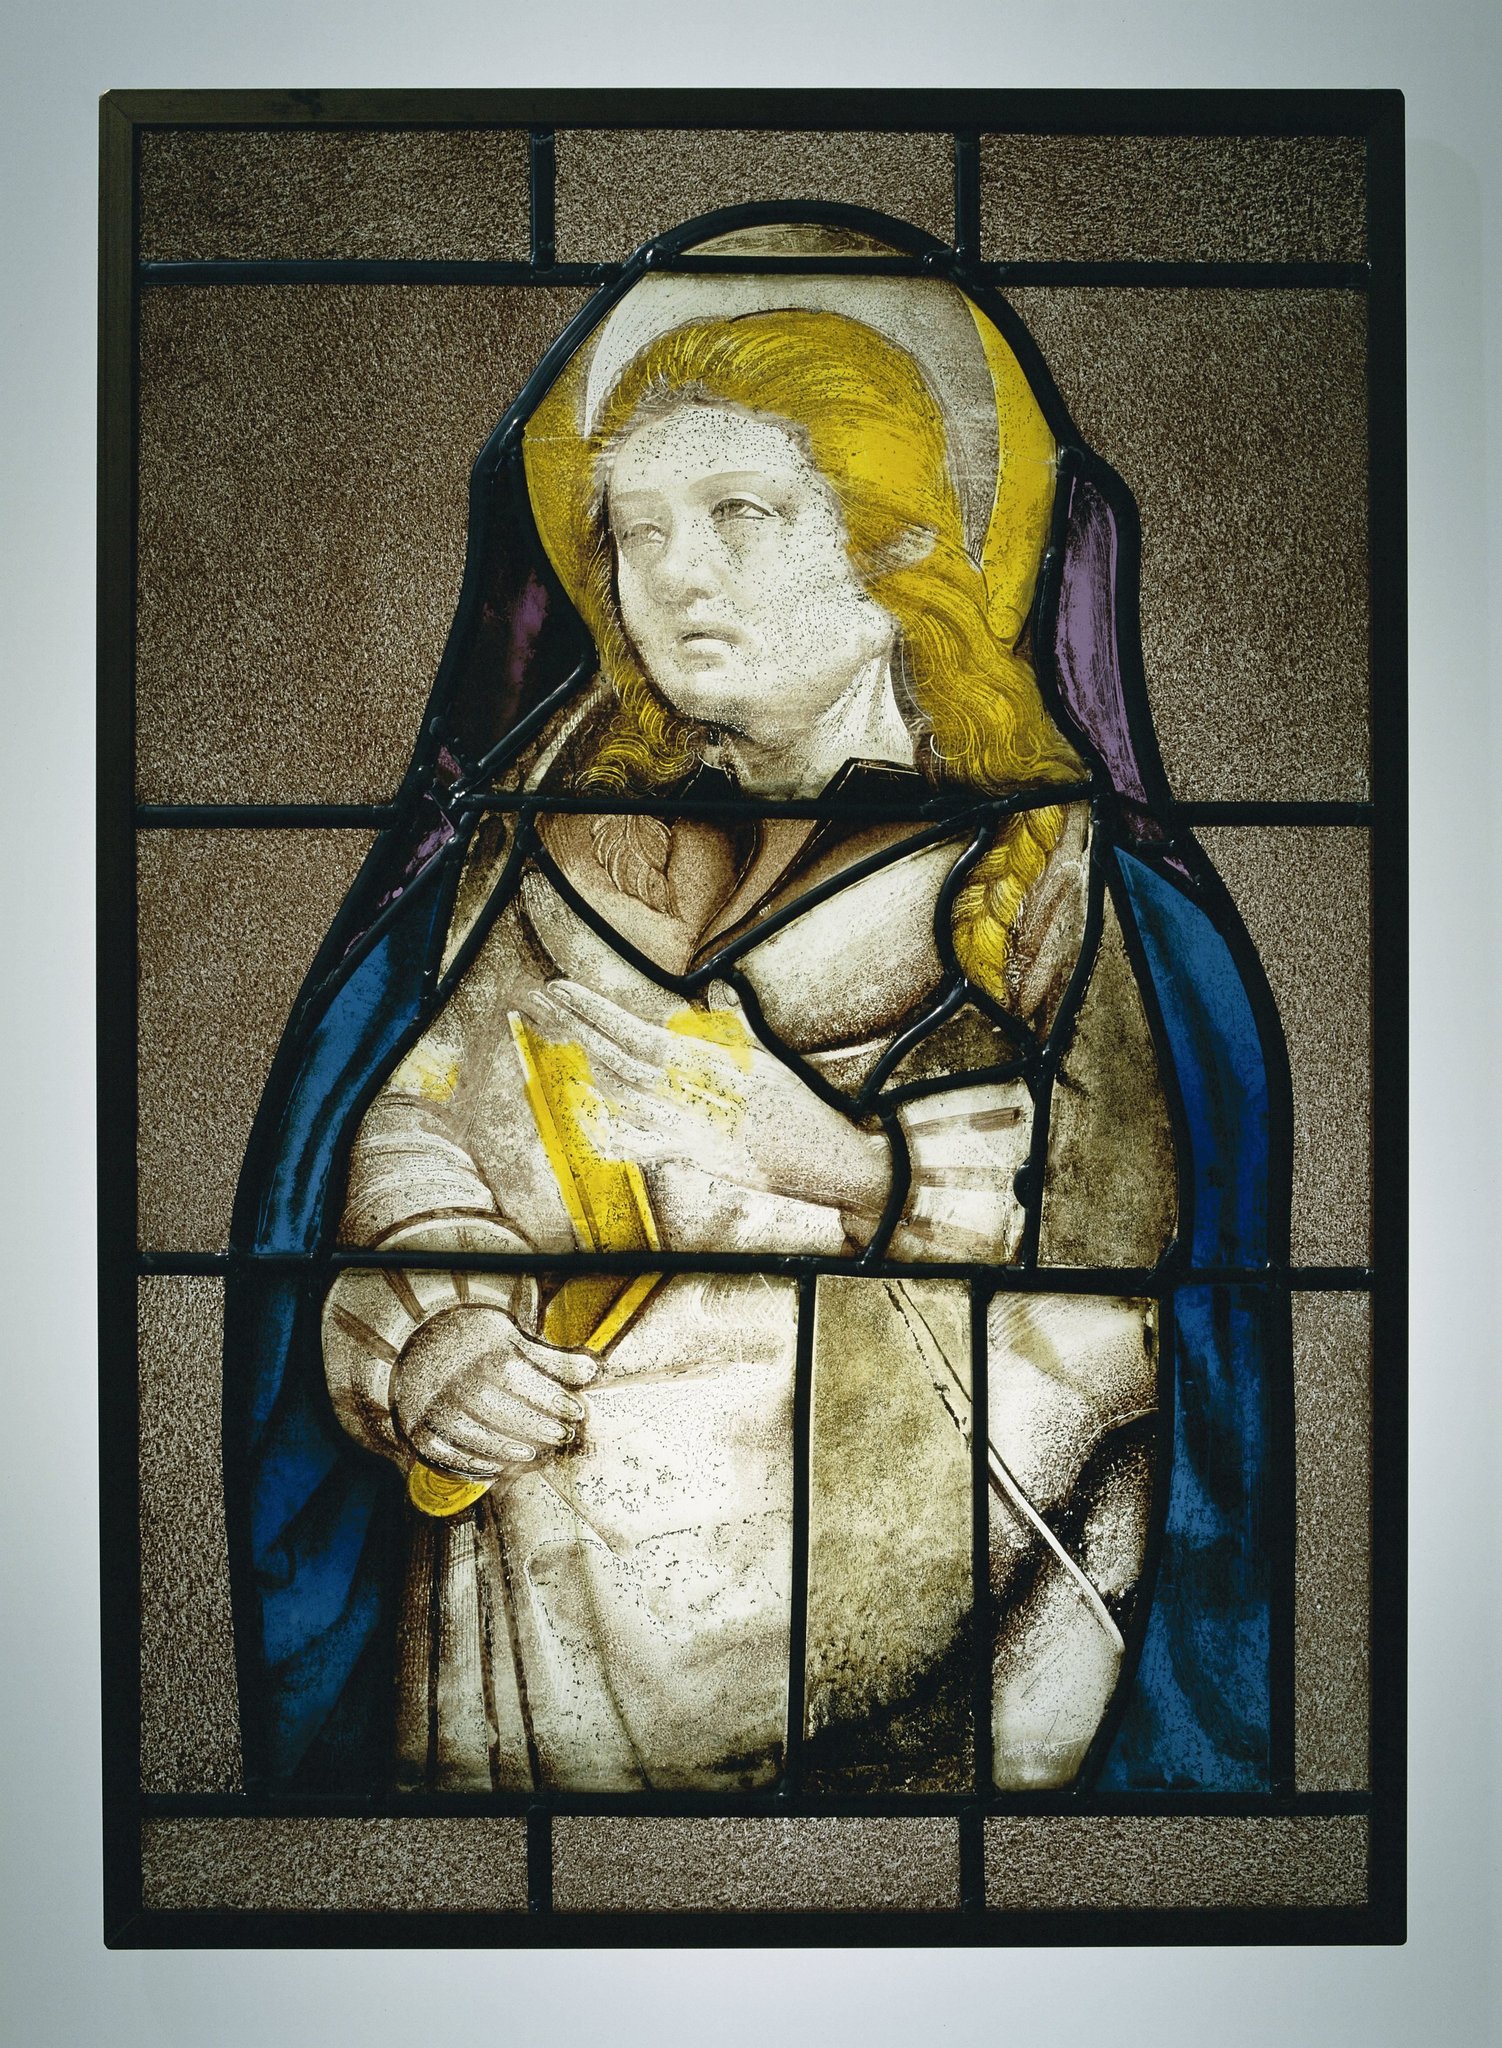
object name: light window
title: Ruit met een heilige met aureool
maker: Anonymous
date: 1515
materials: glass, lead, pigment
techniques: leading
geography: northern netherlands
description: Saint with halo, from St Walburga's Church, Zutphen. Stained glass.Netherlands, c. 1475.